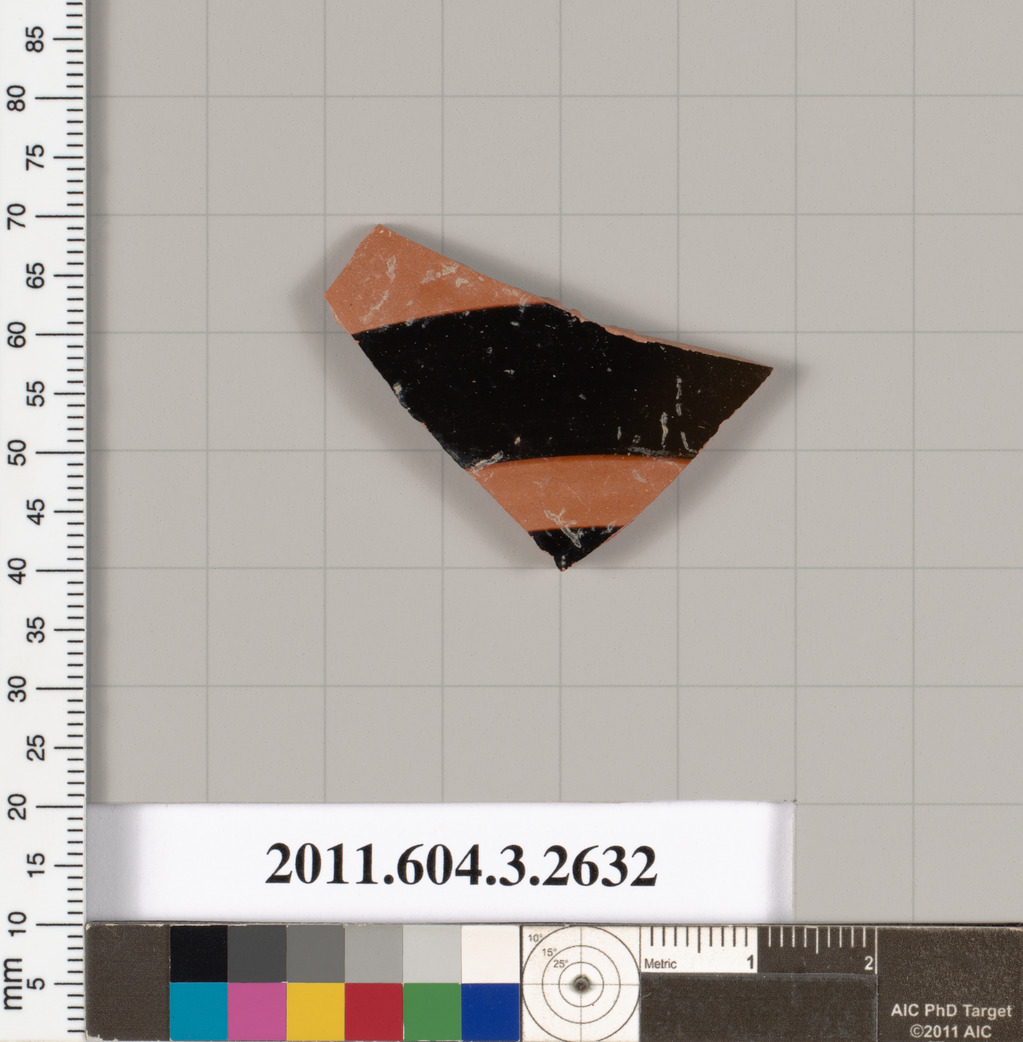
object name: kylix fragment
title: Terracotta fragment of a kylix (drinking cup)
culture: greek, attic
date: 600-401 BCE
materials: terracotta